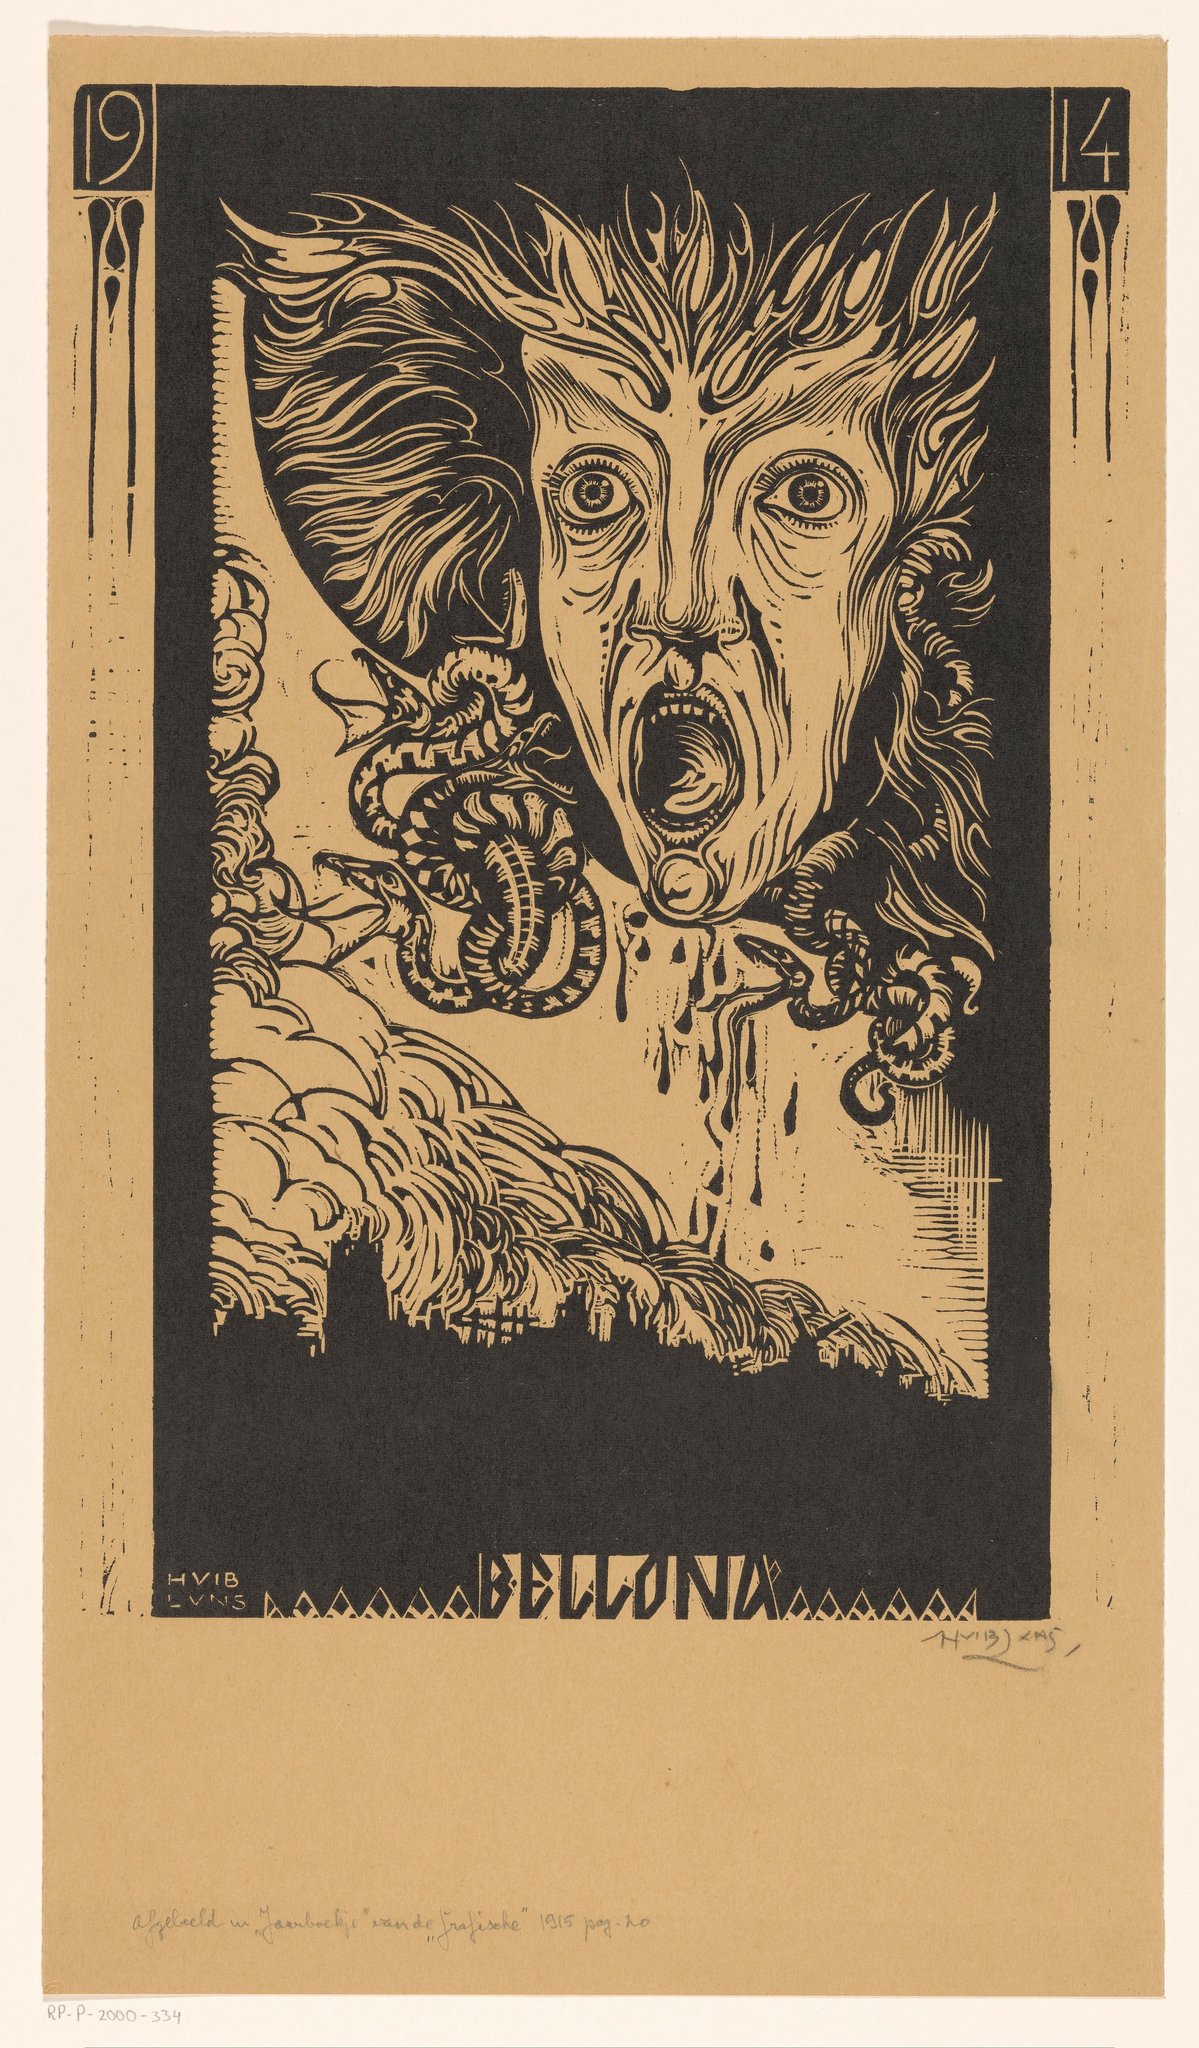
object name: print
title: Bellona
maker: huib luns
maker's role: draughtsman, print maker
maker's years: 1881-1942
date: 1914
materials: paper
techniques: woodcut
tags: bellona (enyo), prospect of city, town panorama, silhouette of city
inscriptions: collector's mark: Lugt 2760, collector's mark: Lugt 2228, collector's mark: ‘Ph. J.’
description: Het bovenste gedeelte van de prent is onder de titel 'Oorlog' gebruikt voor: Wendingen. Maandblad voor bouwen en sieren van "Architectura et Amicitia". Amsterdam: De Hooge Brug 1919. 7/8, p. 25.